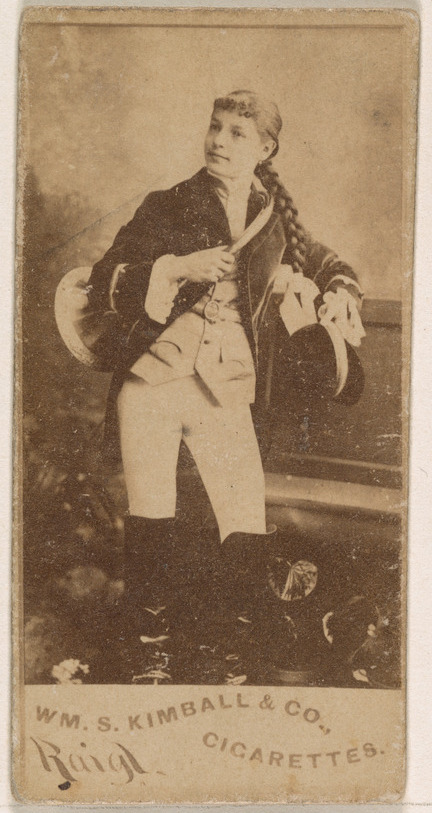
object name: photograph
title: Miss Raigl, from the Actresses series (N203) issued by Wm. S. Kimball & Co.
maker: william s. kimball & company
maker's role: publisher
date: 1889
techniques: color lithograph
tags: portraits,women,actresses